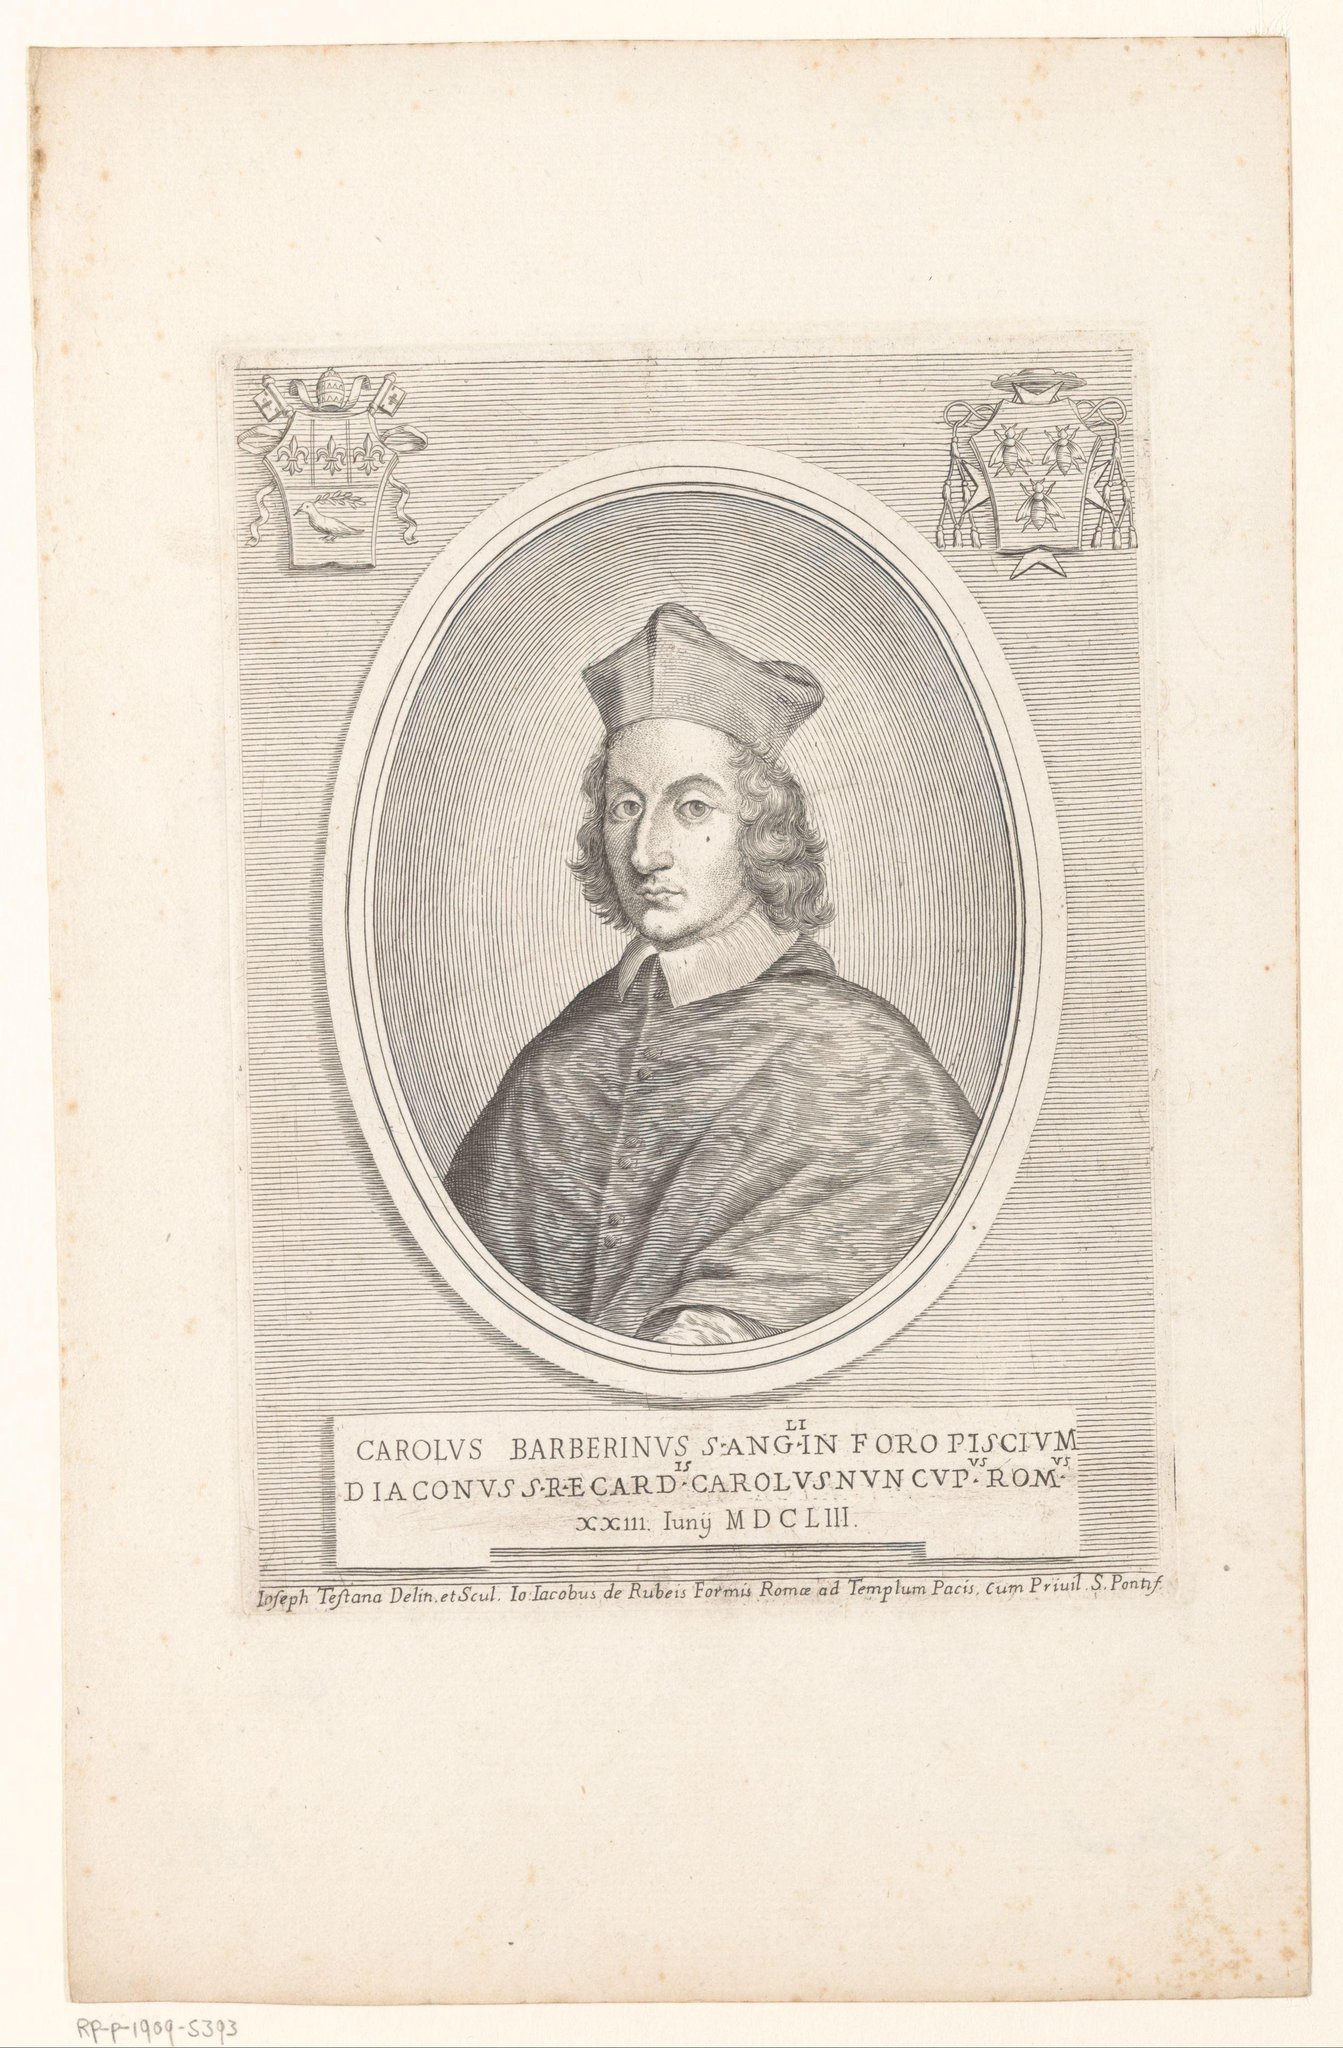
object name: print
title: Portret van kardinaal Carlo Barberini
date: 1658-1679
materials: paper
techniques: engraving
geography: rome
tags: cardinal, historical persons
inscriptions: collector's mark: Lugt 2228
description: Prent uit een reeks van onbekende omvang met portretten van kardinalen. De prenten werden vanaf 1657 vervaardigd in opdracht van uitgever Giovanni Giacomo de’ Rossi, waarna de productie werd voortgezet onder leiding van zijn opvolgers Domenico de’ Rossi en Lorenzo Filippo de’ Rossi, en ten slotte onder leiding van de Calcographia R.C.A.